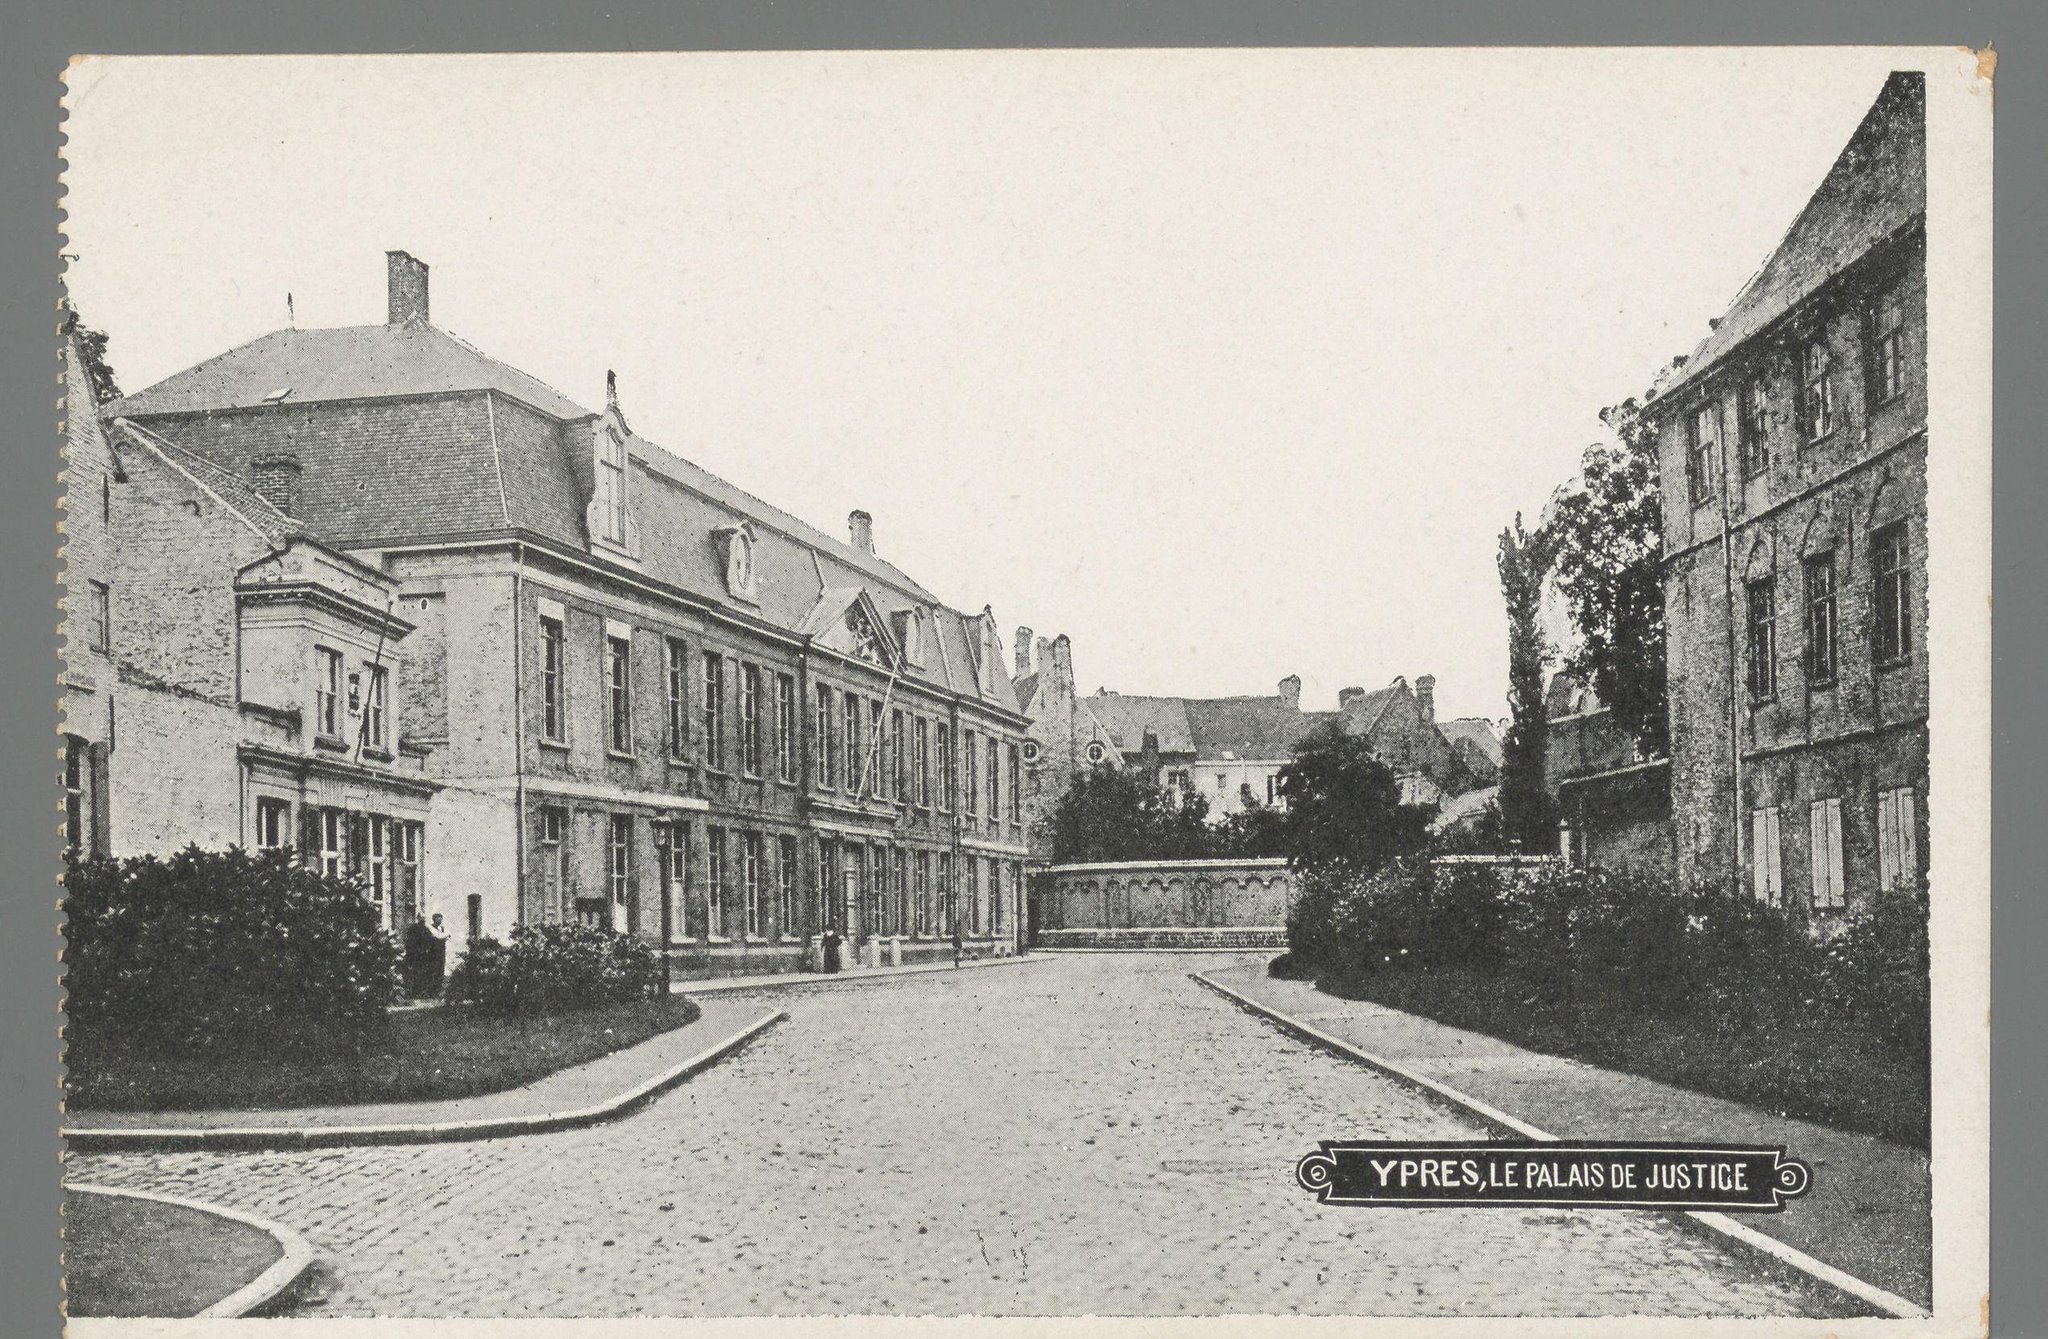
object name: ansichtkaart, prentbriefkaart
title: Ypres, le Palais de Justice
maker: Anonymous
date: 1906-1918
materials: cardboard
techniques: autotype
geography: ieper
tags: court building, city-view, and landscape with man-made constructions